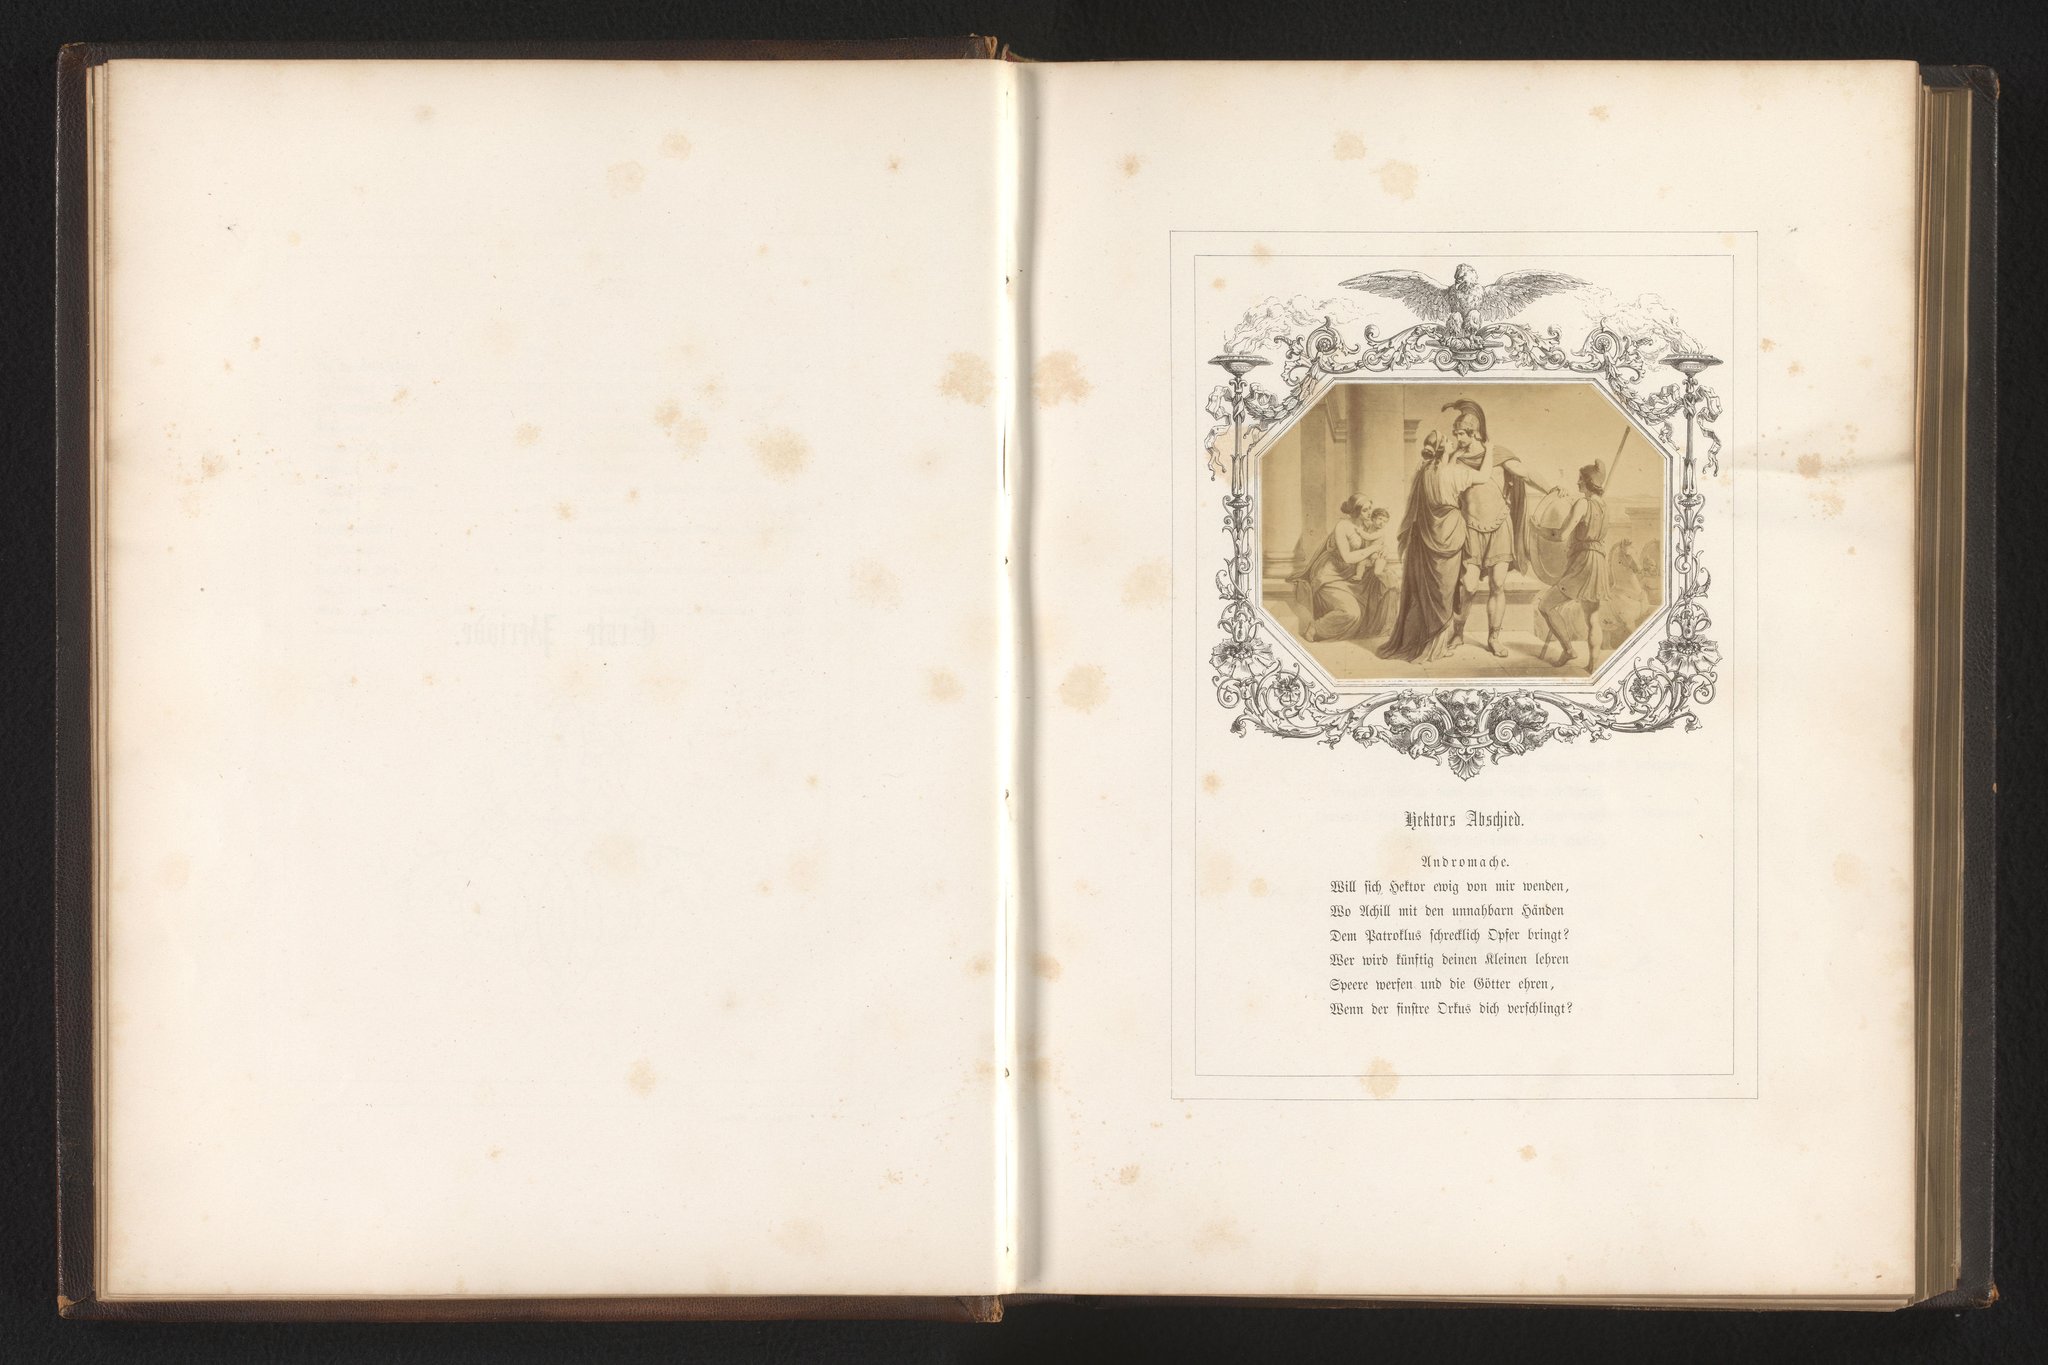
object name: page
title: Fotoreproductie van een tekening van het afscheid van Hektor door Ferdinand Rothbart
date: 1855-1862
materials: paper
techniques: albumen print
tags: hector's farewell to his wife andromache and his young son astyanax